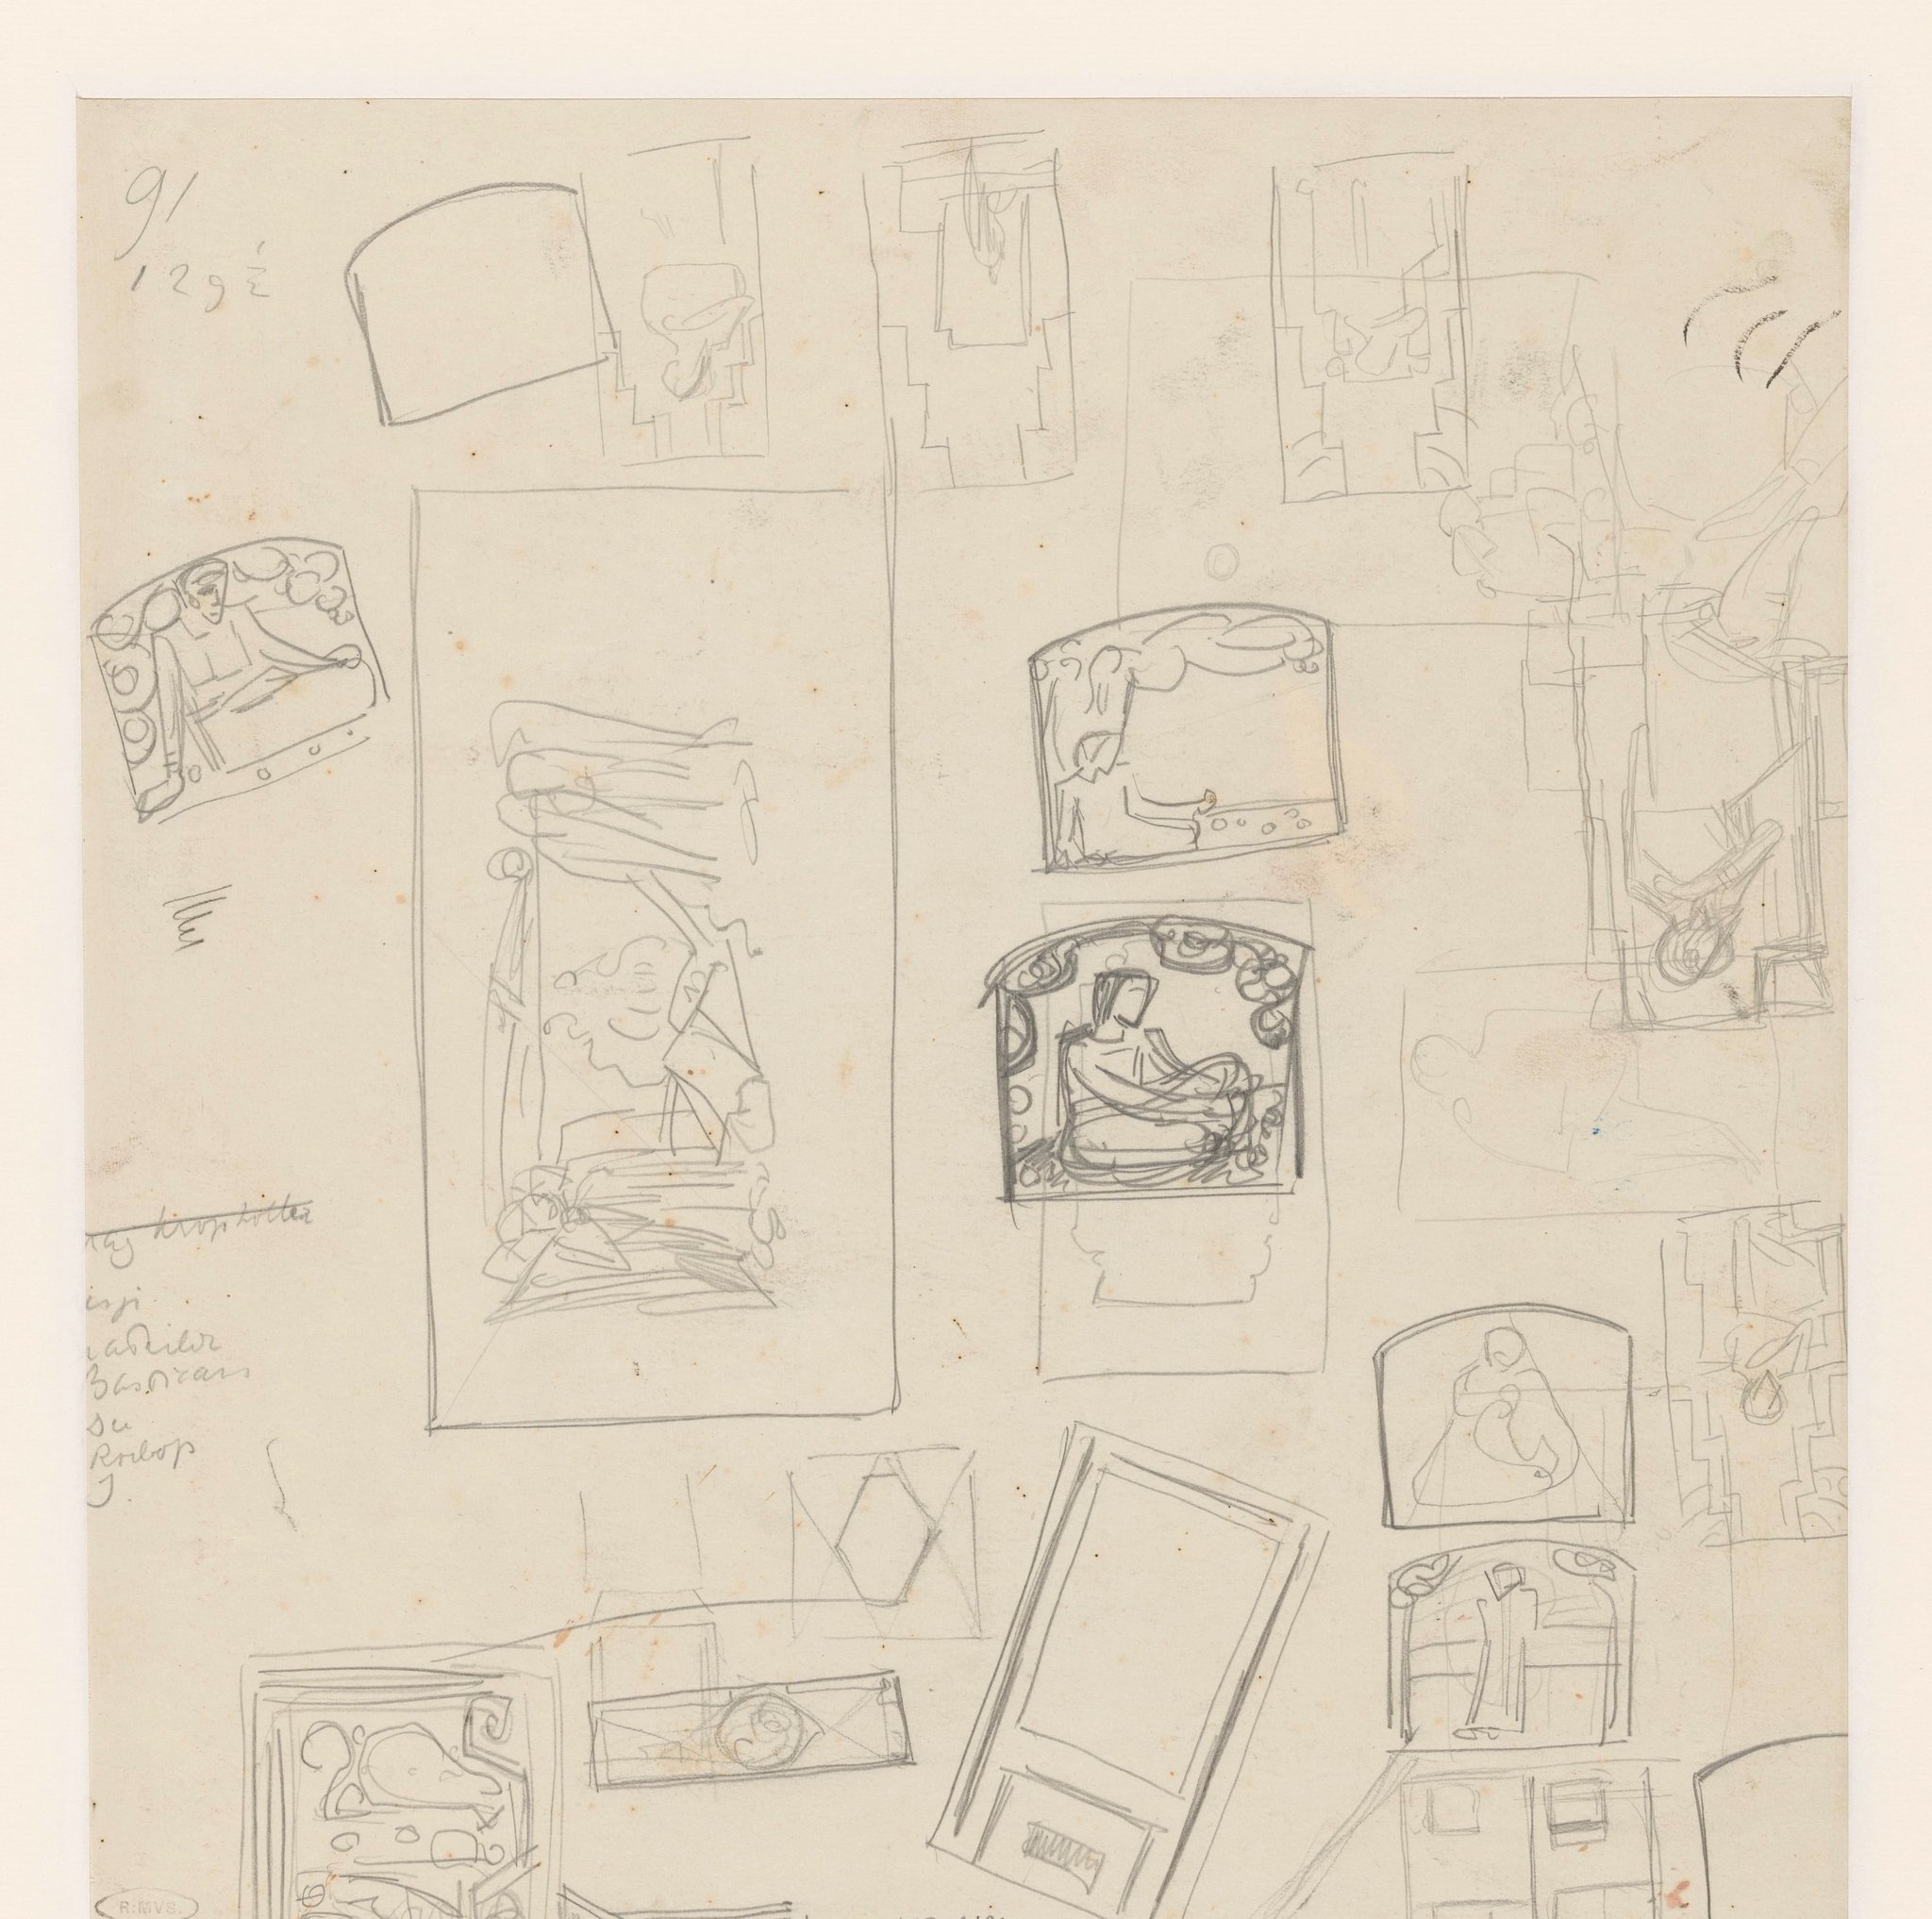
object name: drawing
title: Schetsblad met compositie-studies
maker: richard nicolaüs roland holst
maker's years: 1868-1938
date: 1878-1938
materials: paper, pencil